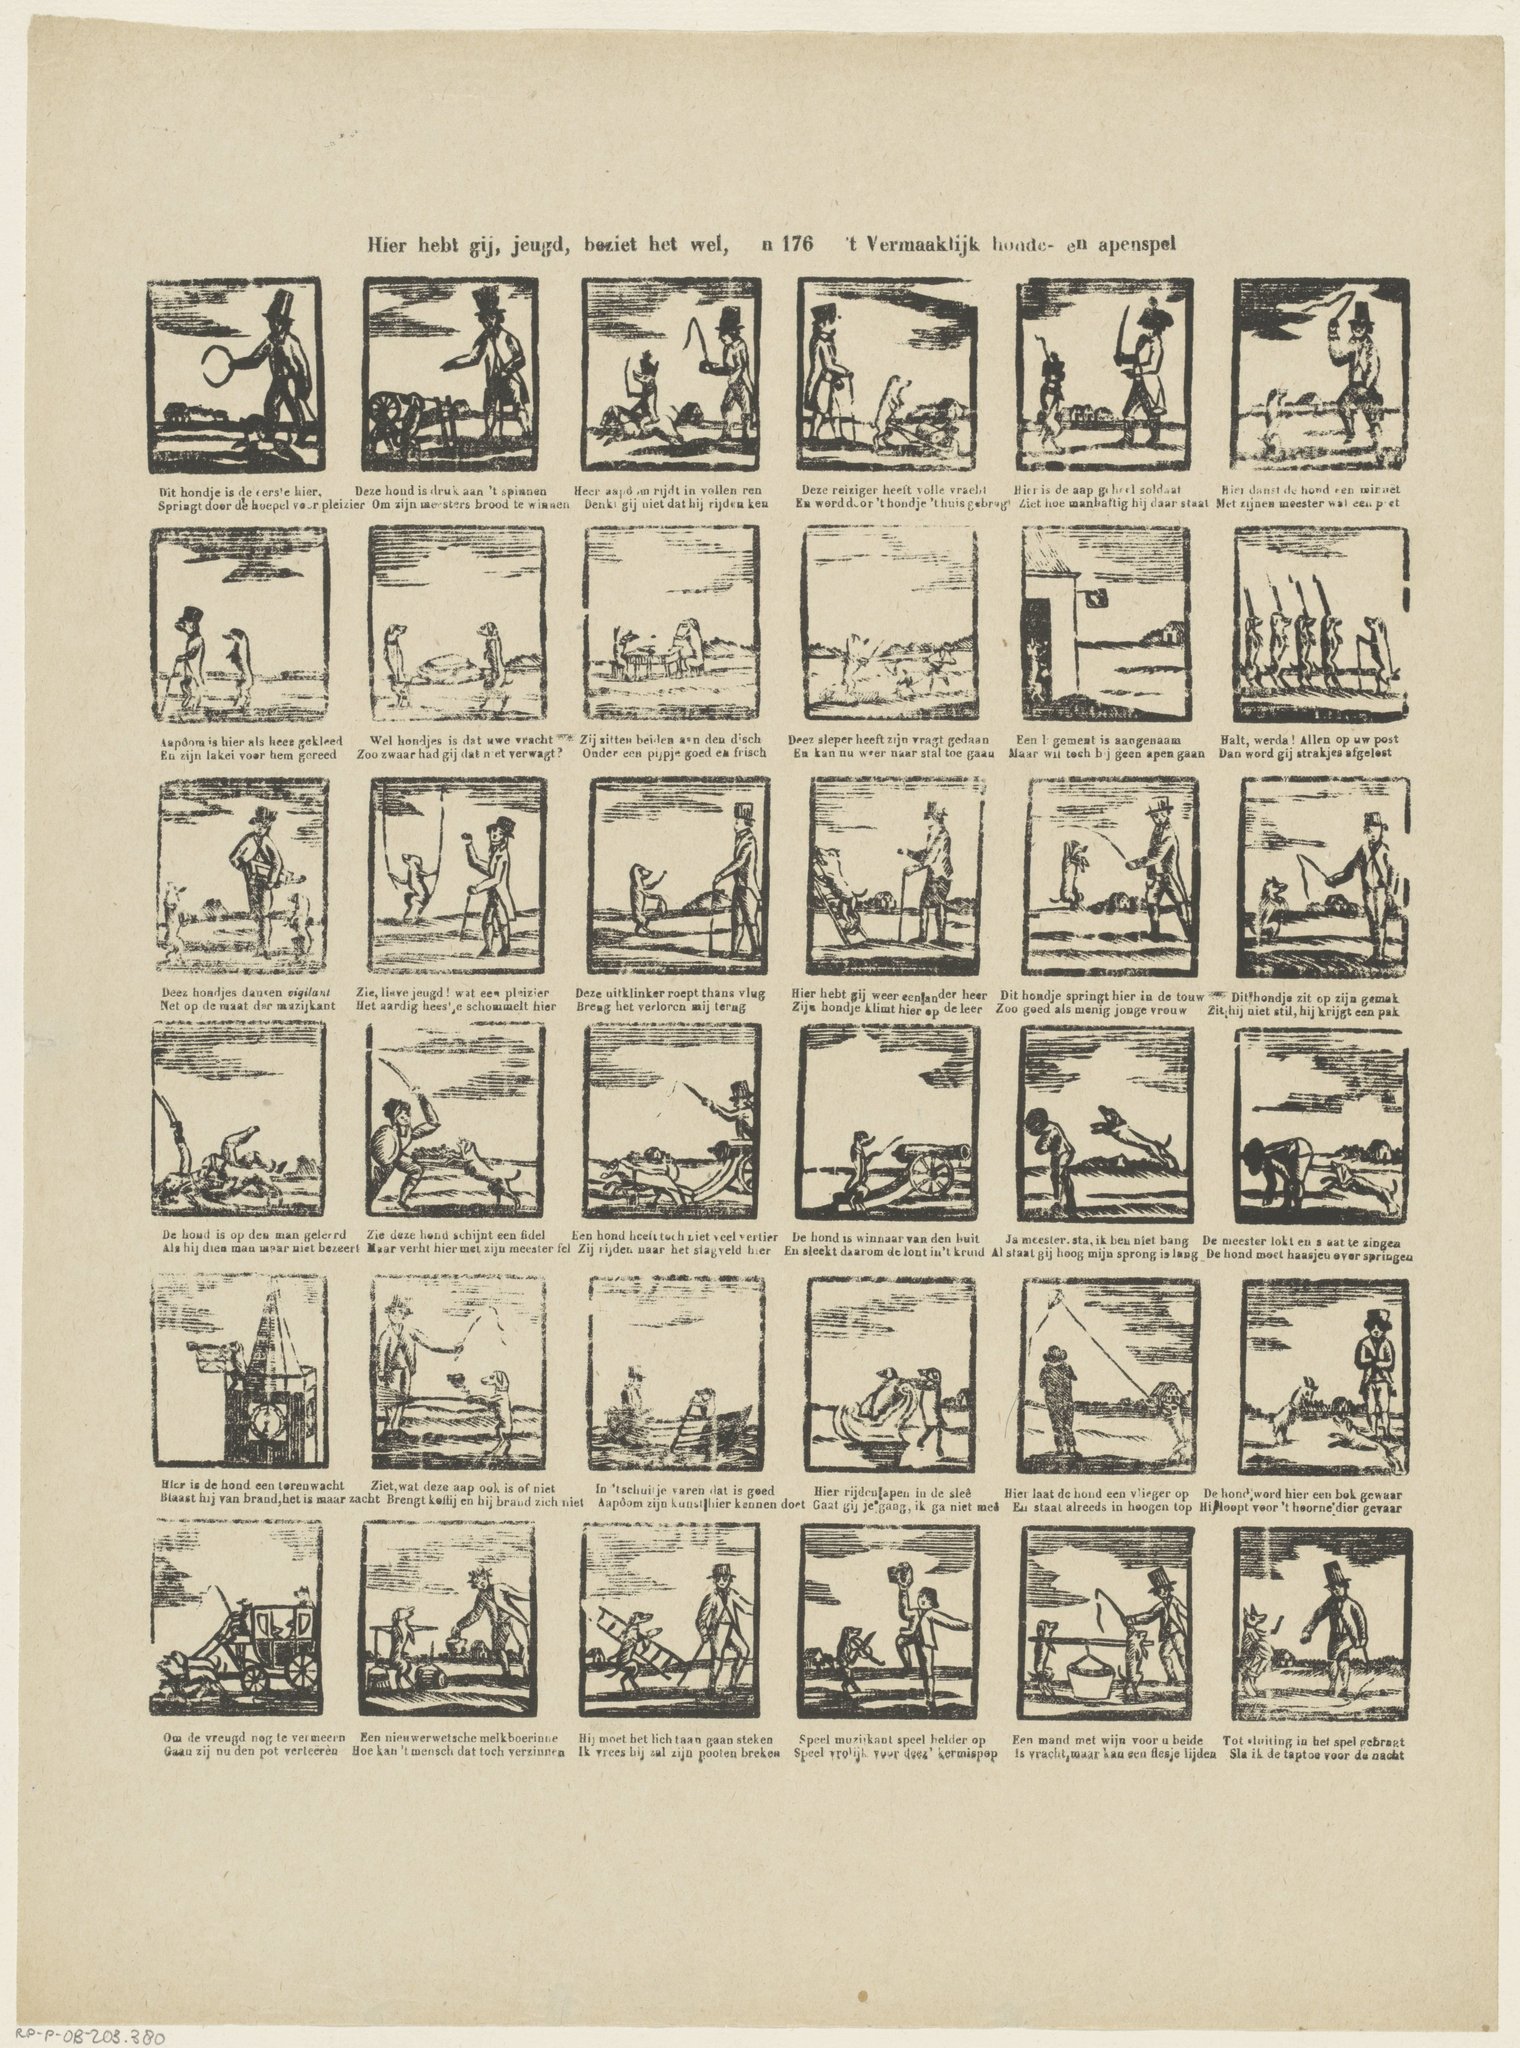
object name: popular print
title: Hier hebt gij, jeugd, beziet het wel, / 't vermaaklijk honde- en apenspel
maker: Anonymous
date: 1856-1900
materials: paper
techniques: letterpress printing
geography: turnhout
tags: monkeys (circus performance), monkeys, apes, dogs (circus performance), dog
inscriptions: collector's mark: Lugt 2760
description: Blad met 36 voorstellingen van honden en apen die kunstjes doen. Onder elke afbeelding een tweeregelig vers. Genummerd midden boven: n 176.